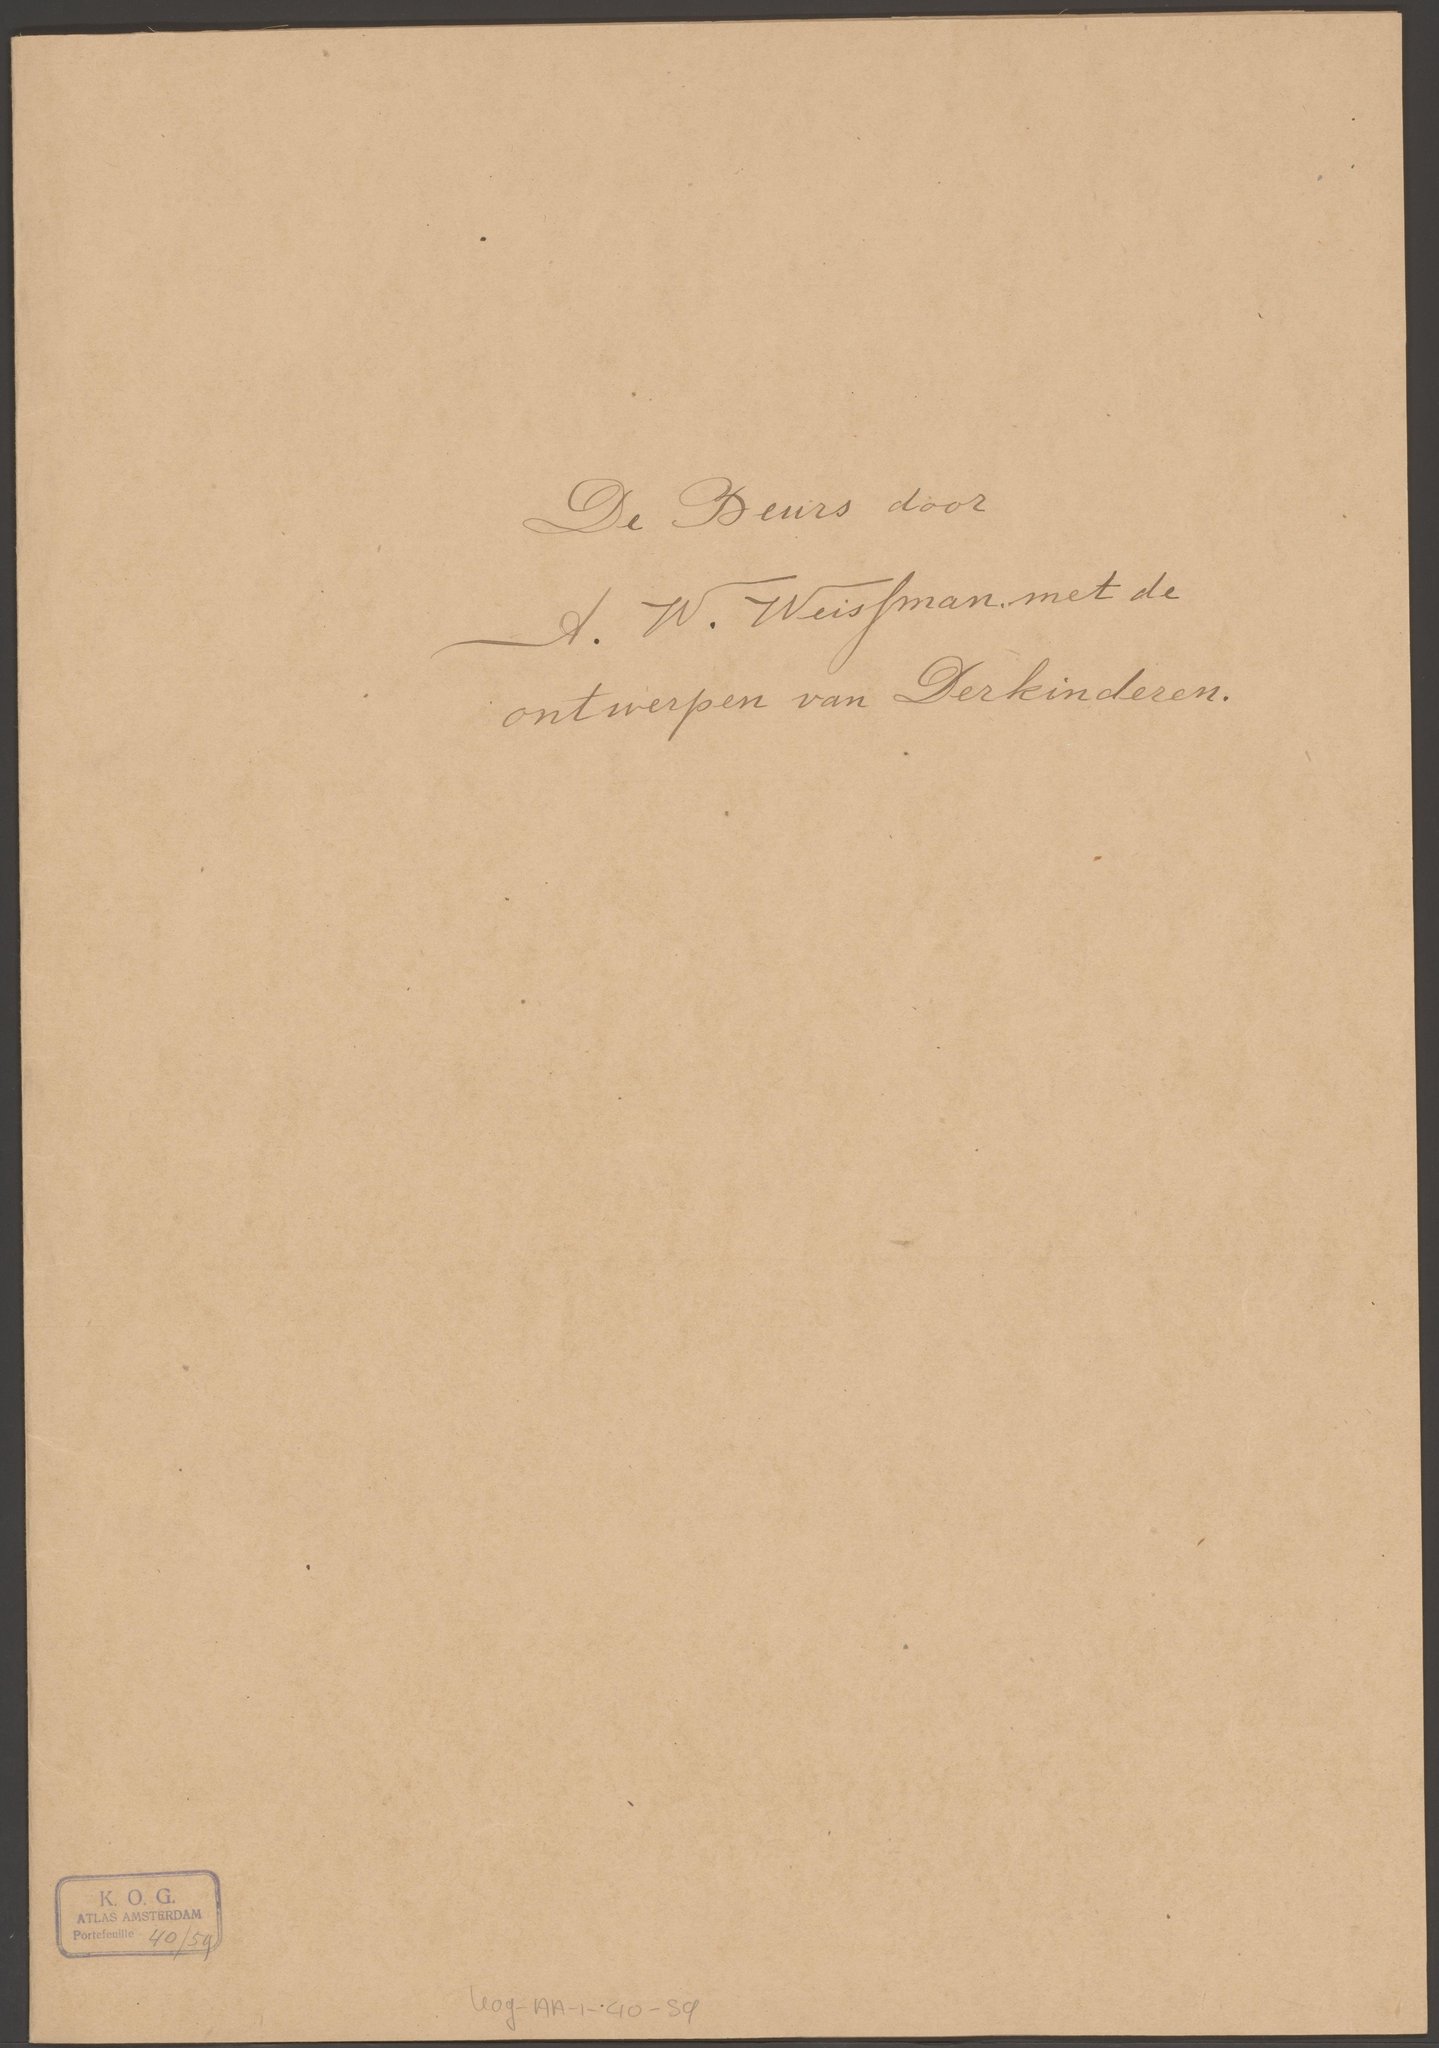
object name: article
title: Ontwerp van A.J. Derkinderen voor de beschildering van de Zaal in de Nieuwe Beurs, bestemd voor de Kamer van Koophandel en voor de Officieele Recepties der stad Amsterdam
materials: paper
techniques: letterpress printing, line block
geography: amsterdam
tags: stock exchange, stock-market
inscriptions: collector's mark: Lugt 1641b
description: Artikelen uit: De Amsterdammer 27 (1903), nr. 1338, 15 februari 1903, p. 7-8 / De Amsterdammer 27 (1903), nr. 1339, 22 februari 1903, p. 7-8 / De Amsterdammer 27 (1903), nr. 1341, 8 maart 1903, p. 7-8 / De Amsterdammer 27 (1903), nr. 1342, 15 maart 1903, p. 7-8 / De Amsterdammer 27 (1903), nr. 1343, 22 maart 1903, p. 7-8 / De Amsterdammer 27 (1903), nr. 1344, 29 maart 1903, p. 7-8 / De Amsterdammer 26 (1902), nr. 1326, 23 november 1902, p. 7-8 / De Amsterdammer 26 (1902), nr. 1328, 7 december 1902, p. 7-8 / De Amsterdammer 26 (1902), nr. 1329, 14 december 1902, p. 7-8 / De Amsterdammer 27 (1903), nr. 1337, 8 februari 1903, p. 7-8 / Algemeen Handelsblad 78 (1905), nr. 24652, 16 december 1905, p. 5-8.